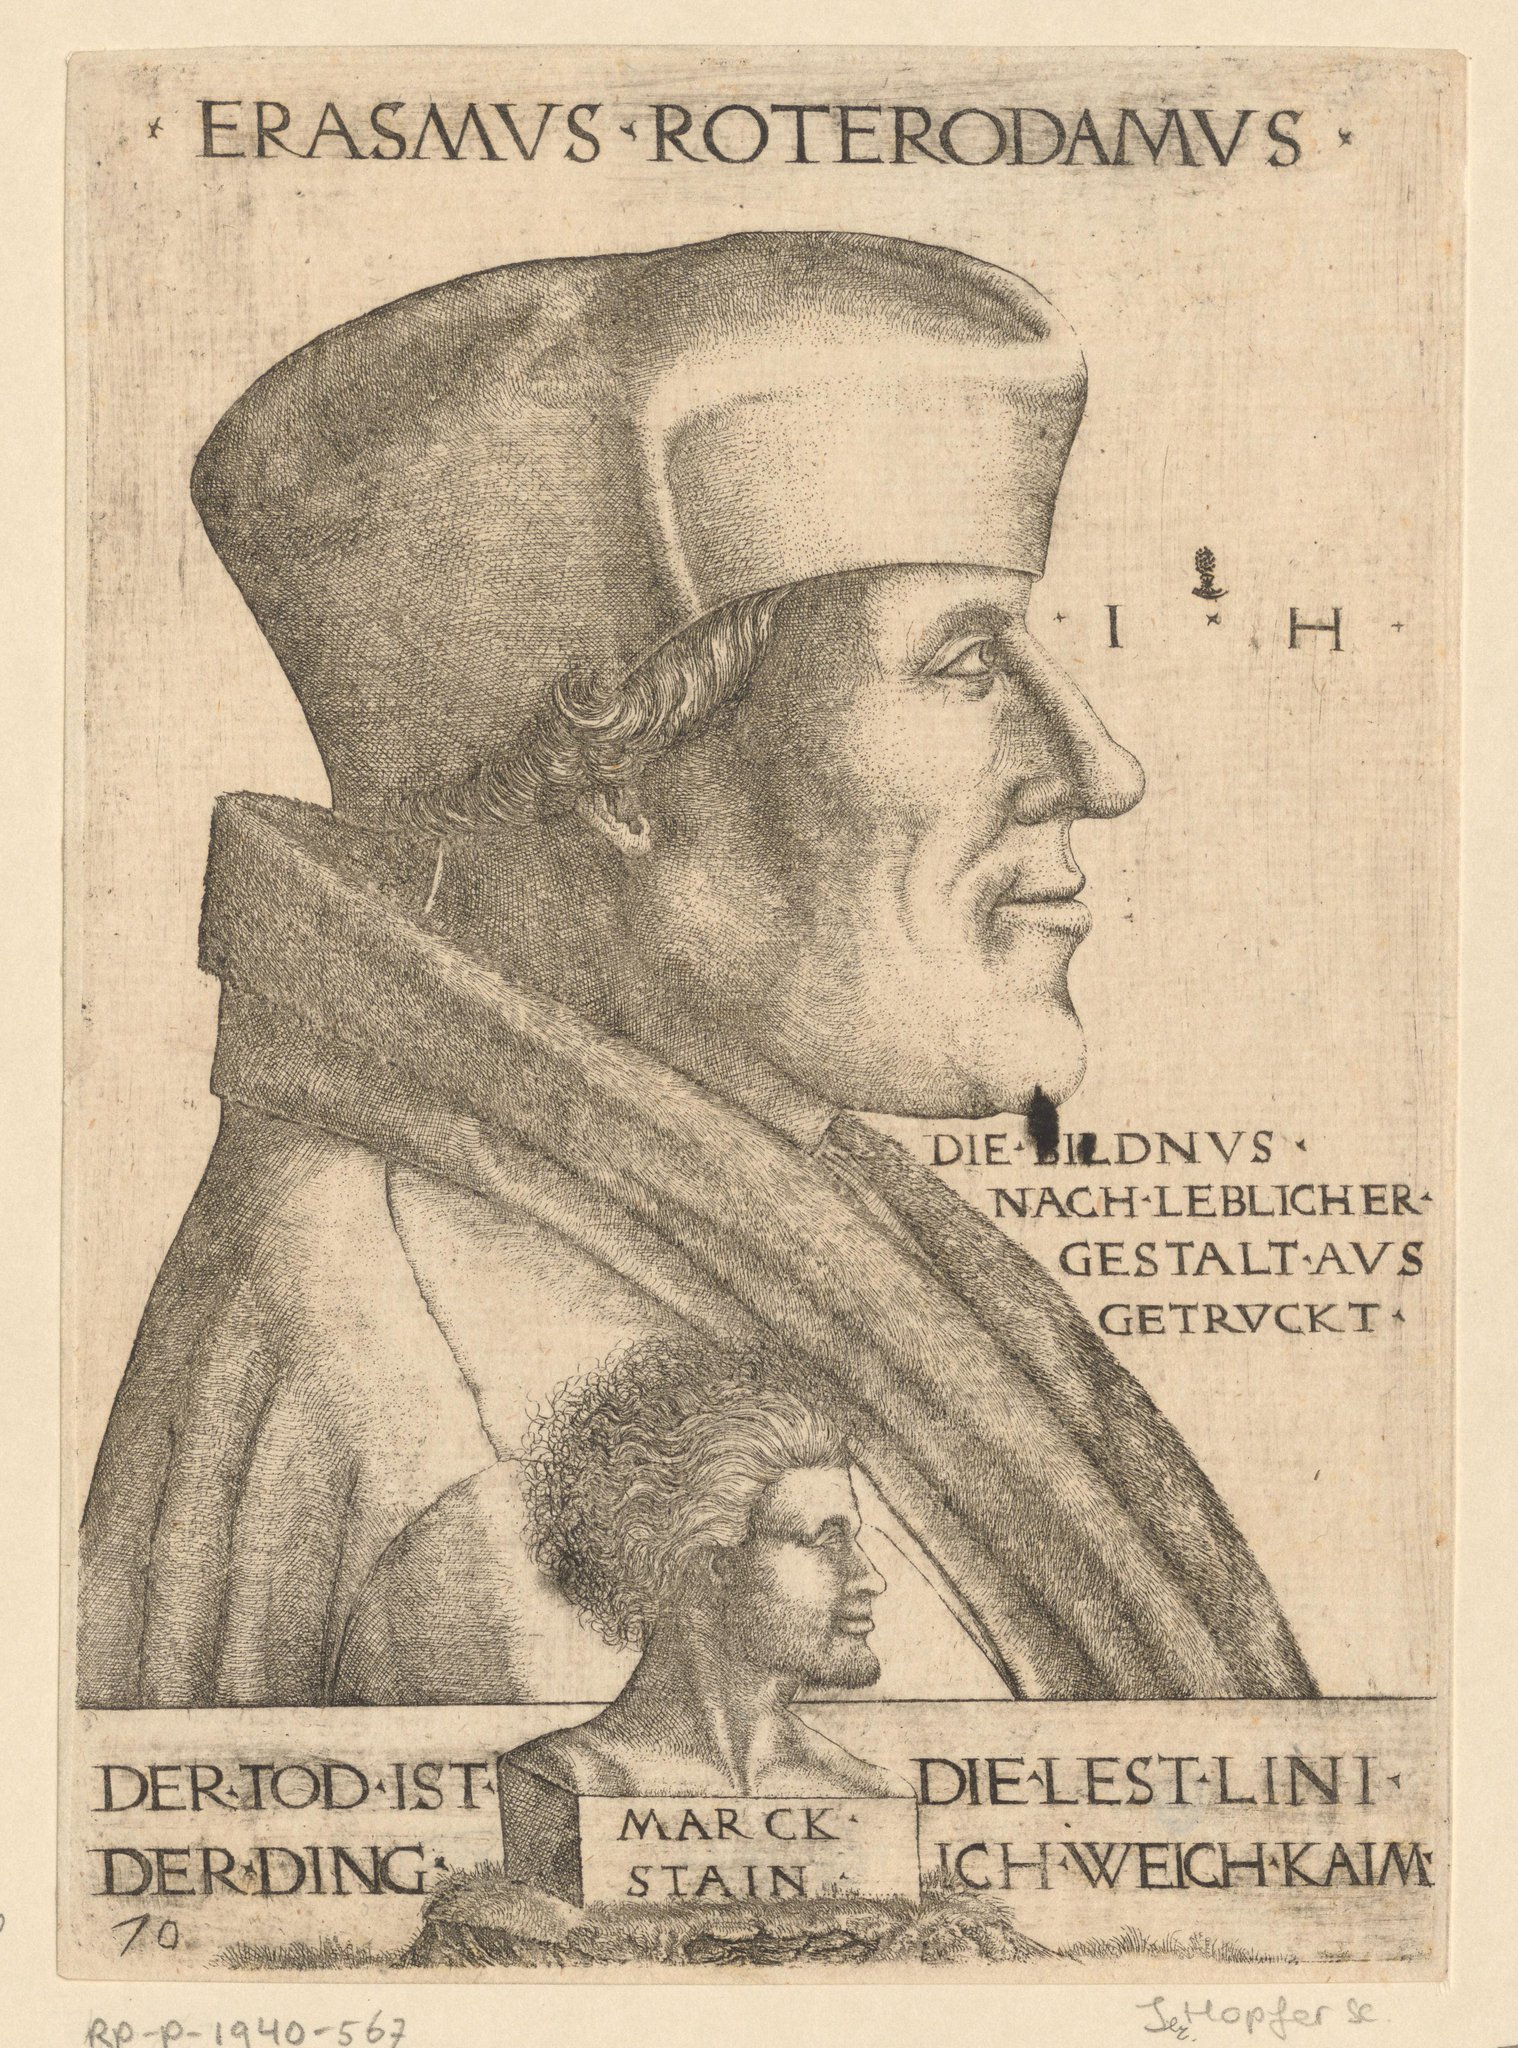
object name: print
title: Operae Hopferianae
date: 1520-1550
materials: paper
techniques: etching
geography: nuremberg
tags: desiderius erasmus, historical persons, terminus, piece of sculpture, reproduction of a piece of sculpture, scholar, philosopher (+ portrait of scholar, scientist)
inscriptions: collector's mark: Lugt 2760, collector's mark: Lugt 2228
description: David Funck (1642-1709) kocht 230 platen van de prentmakers uit de familie Hopfer aan, nummerde deze (nu bekend als het Funck nummer) en herdrukte de verder onaangetaste platen onder de titel Operae Hopferianae in 1684 in Neurenberg (Metzger, 2009).